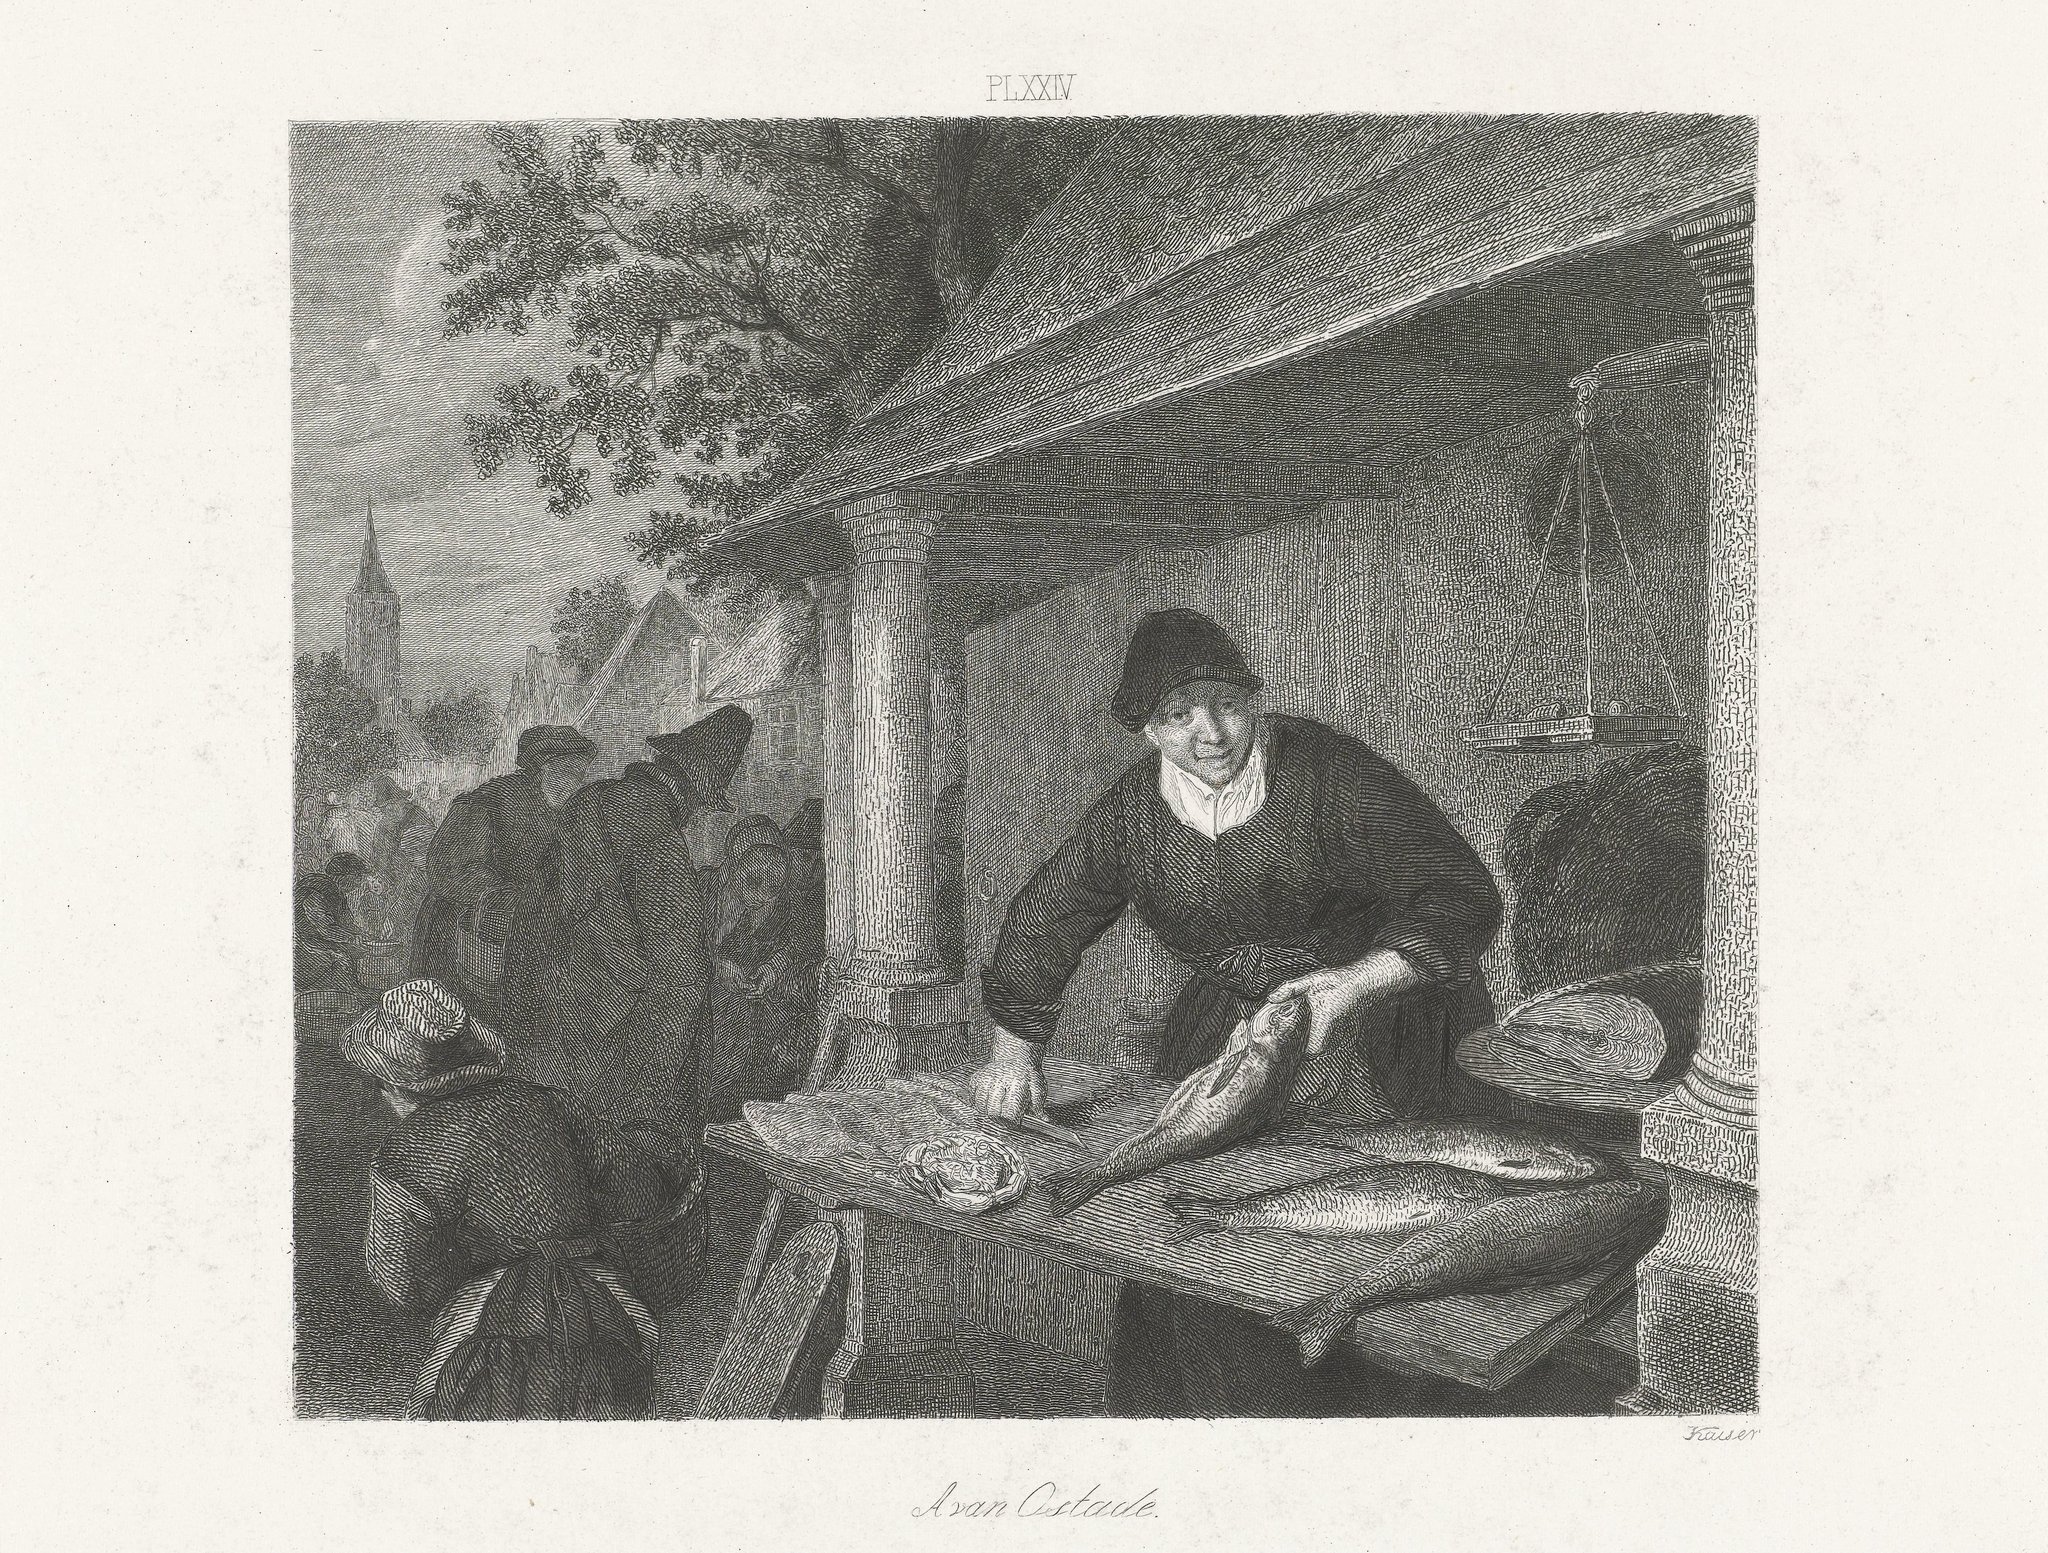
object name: print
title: Hollandse meesters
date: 1823-1900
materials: paper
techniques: etching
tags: fishes, stall, booth (~ market)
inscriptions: collector's mark: Lugt 2228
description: Een visverkoopster met een mes en een vis in haar handen. Op de achtergrond enkele figuren en de contouren van huizen en een kerktoren. De prent maakt deel uit van een serie van 25 prenten naar Hollandse meesters. Boven de afbeelding: PL XXIV.